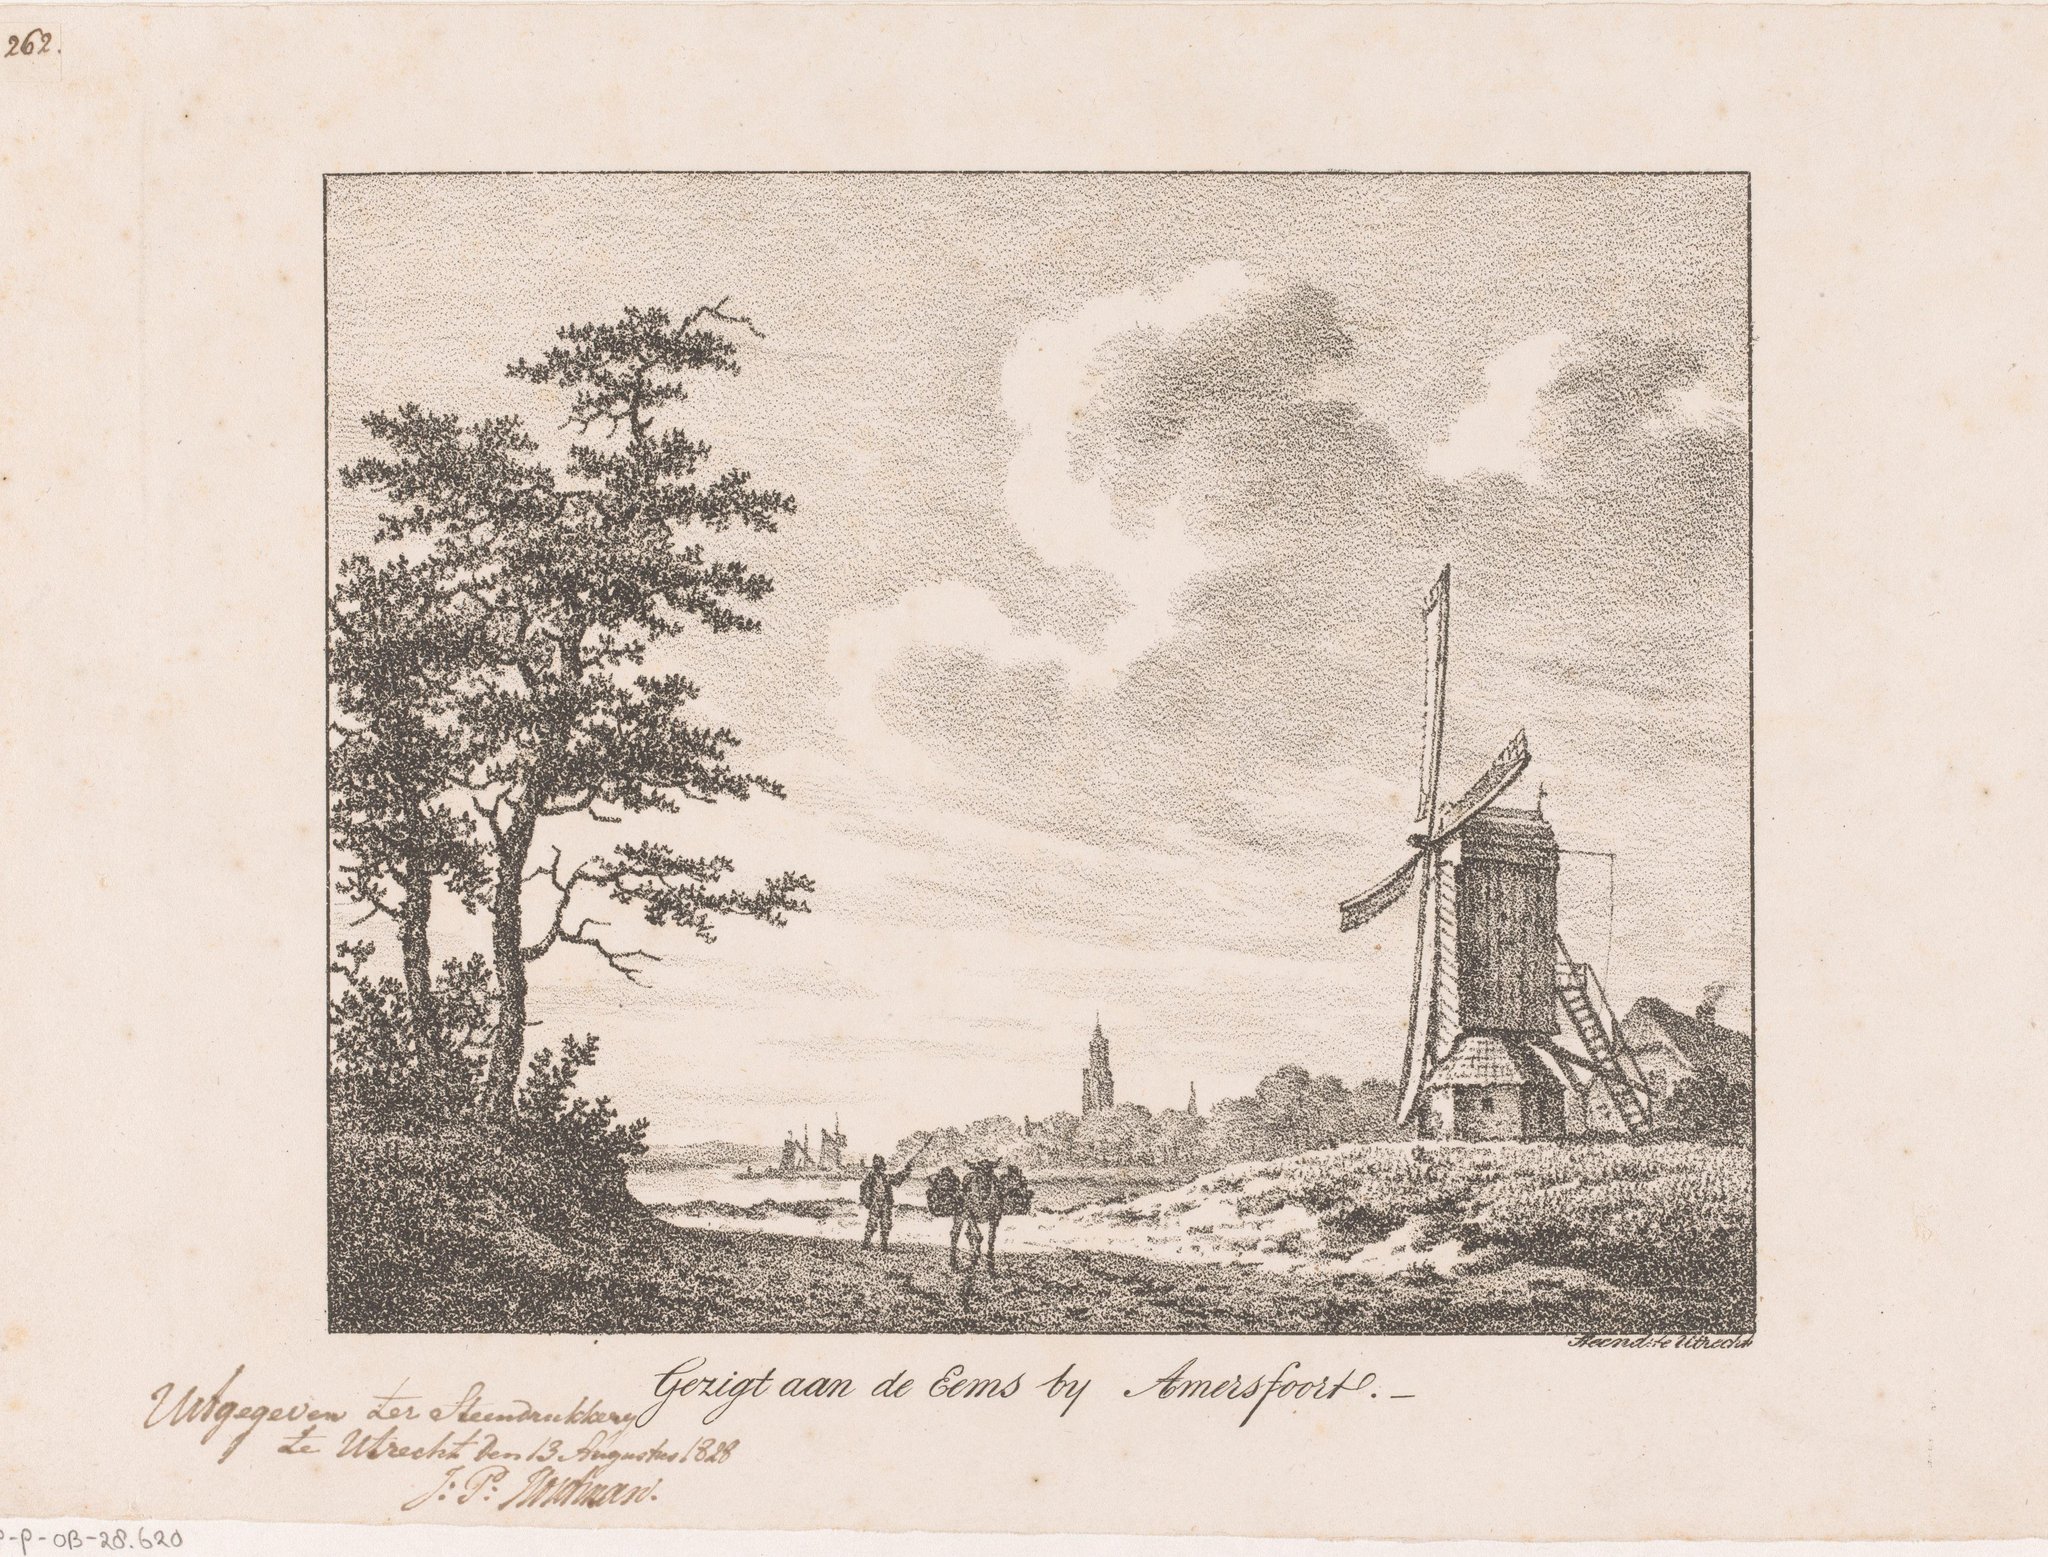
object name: print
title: Gezicht op de Eem bij Amersfoort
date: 1828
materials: paper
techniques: lithograph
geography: utrecht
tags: city-view, and landscape with man-made constructions, windmill in landscape, landscapes in the temperate zone (+ landscape with figures, staffage), parts of church exterior and annexes: tower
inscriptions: inscription: ‘Uitgegeven ter Steendrukkerij / te Utrecht den 13 Augustus 1828 / J: P: Houtman’, collector's mark: Lugt 2228, number: ‘262’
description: Op de weg langs het water loopt een man met een ezel. Rechts een windmolen. In de verte een kerktoren.